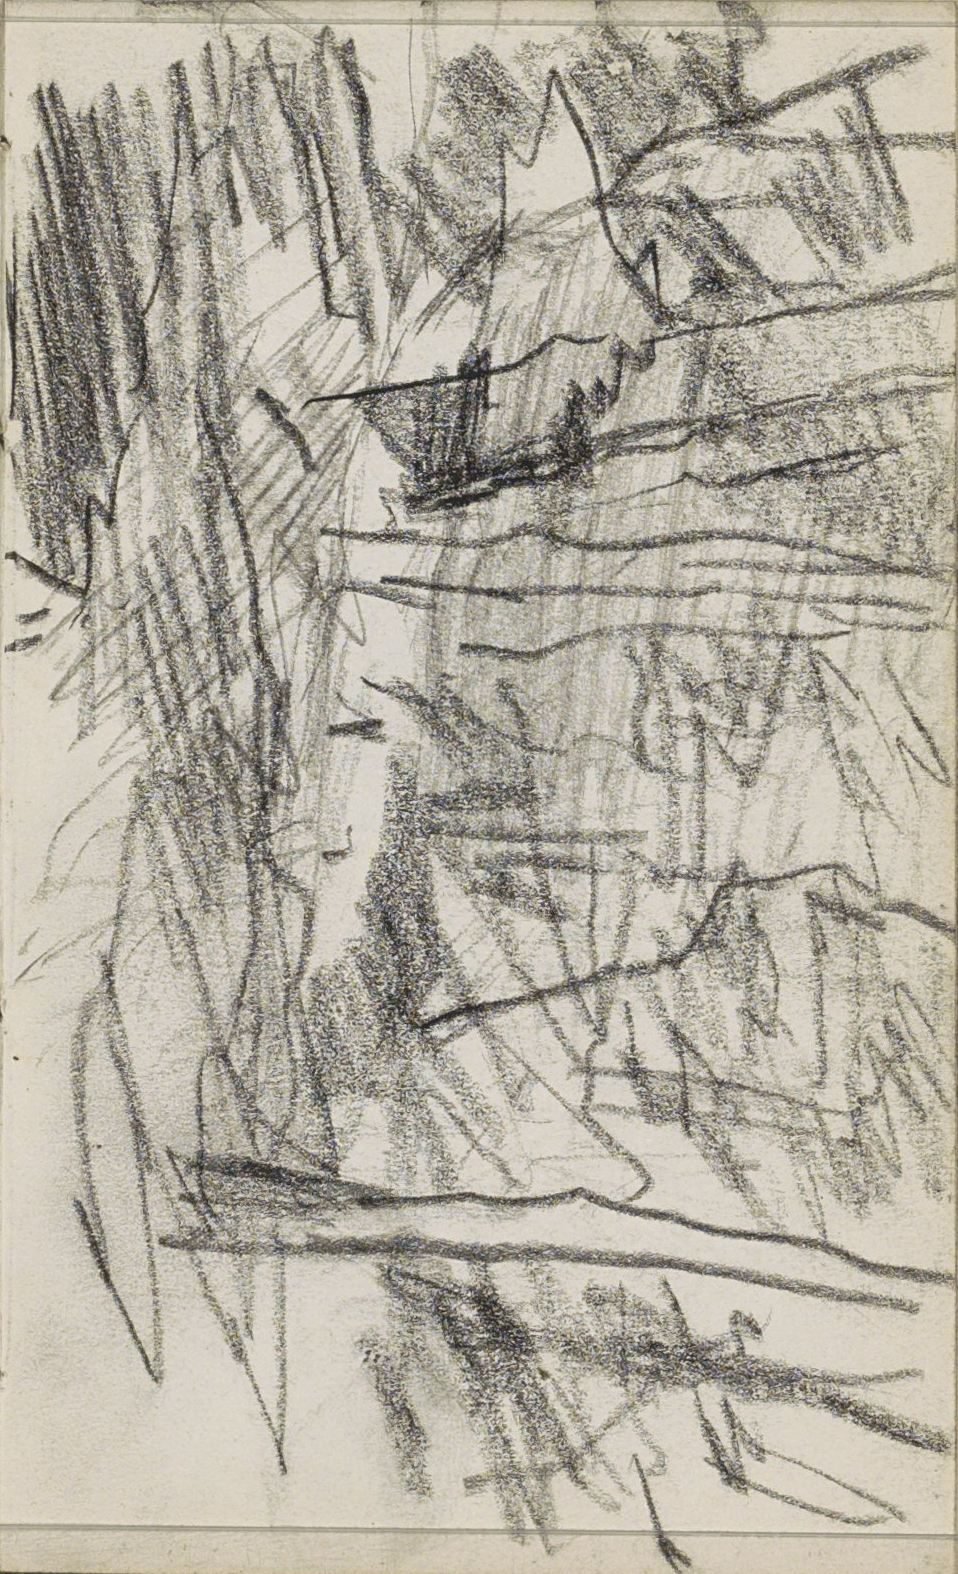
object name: sketchbook leaf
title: Bos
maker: anton mauve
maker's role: draughtsman, painter, print maker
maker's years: 1838-1888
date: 1848-1888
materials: chalk, paper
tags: forest, wood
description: Blad 44 recto uit een schetsboek met 53 bladen.